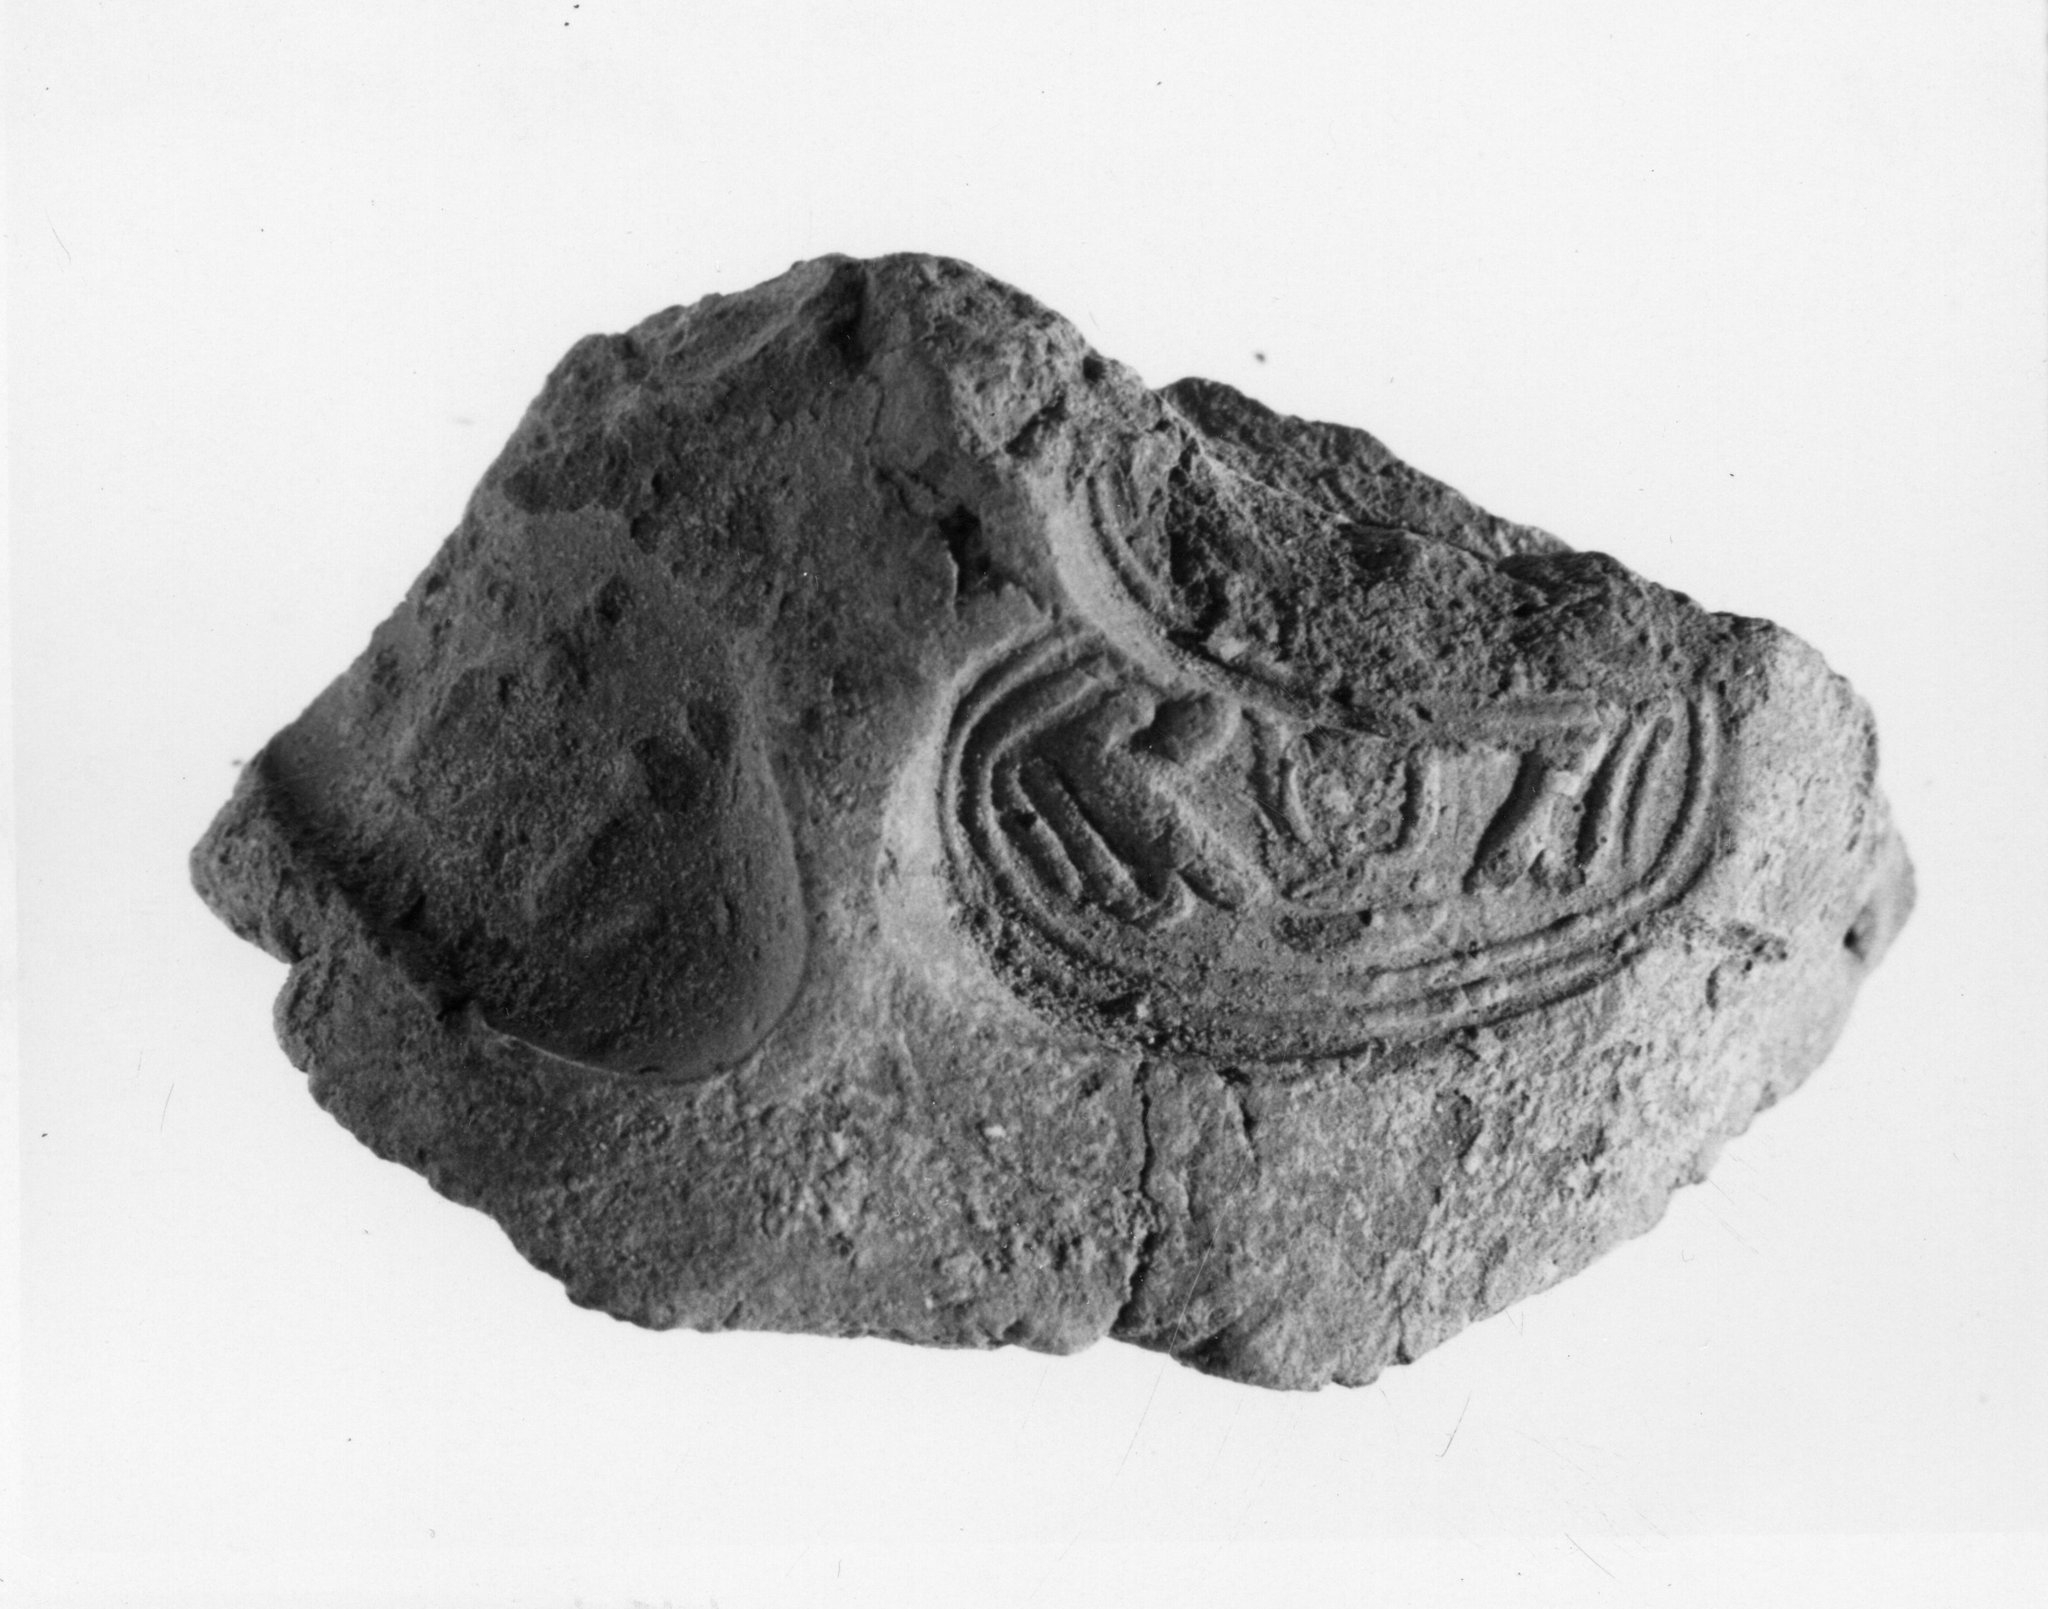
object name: sealing, amenhotep iii, nebmaatre, cobra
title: Document Sealing With Multiple Seal Impressions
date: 1390-1352 BCE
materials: mud